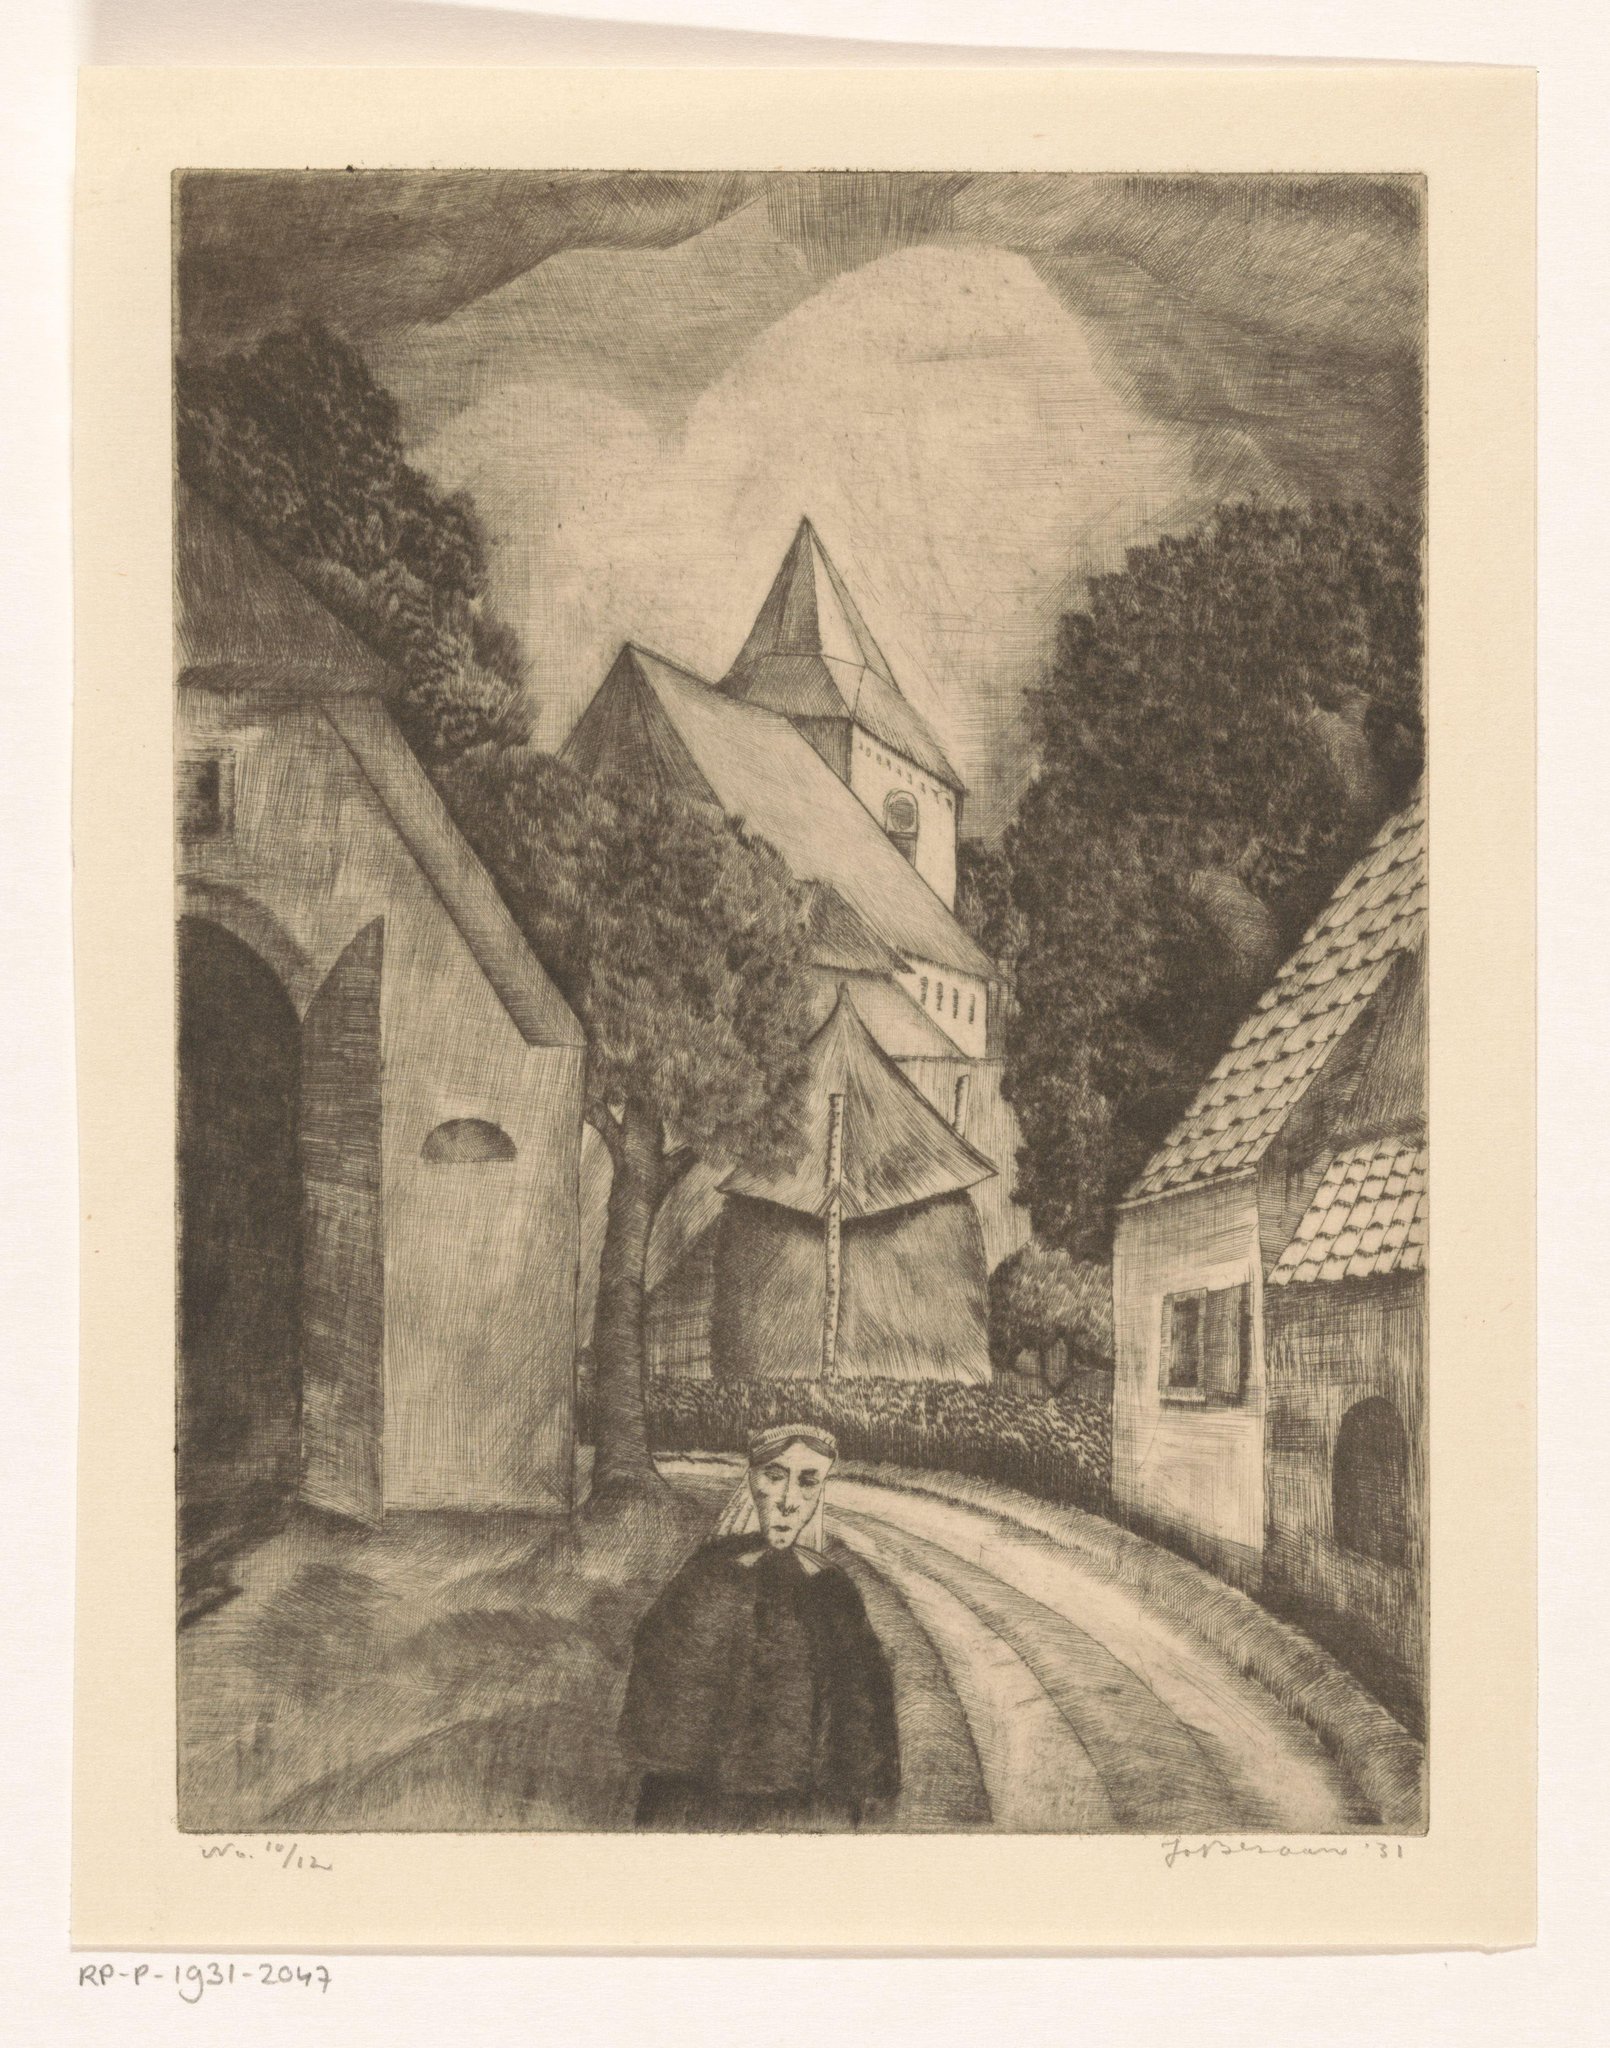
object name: print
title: Vrouw op de dorpsweg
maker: jo bezaan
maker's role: draughtsman, print maker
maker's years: 1894-1952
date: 1931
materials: paper, ink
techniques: drypoint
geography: putten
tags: farmers - aa - female farmer, farmer's wife, folk costume, regional costume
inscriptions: edition: ‘no. 10/12’, signature and date: ‘JoBezaan '31’, collector's mark: Lugt 2228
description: Vrouw in klederdracht bij de bocht van een dorpsweg.